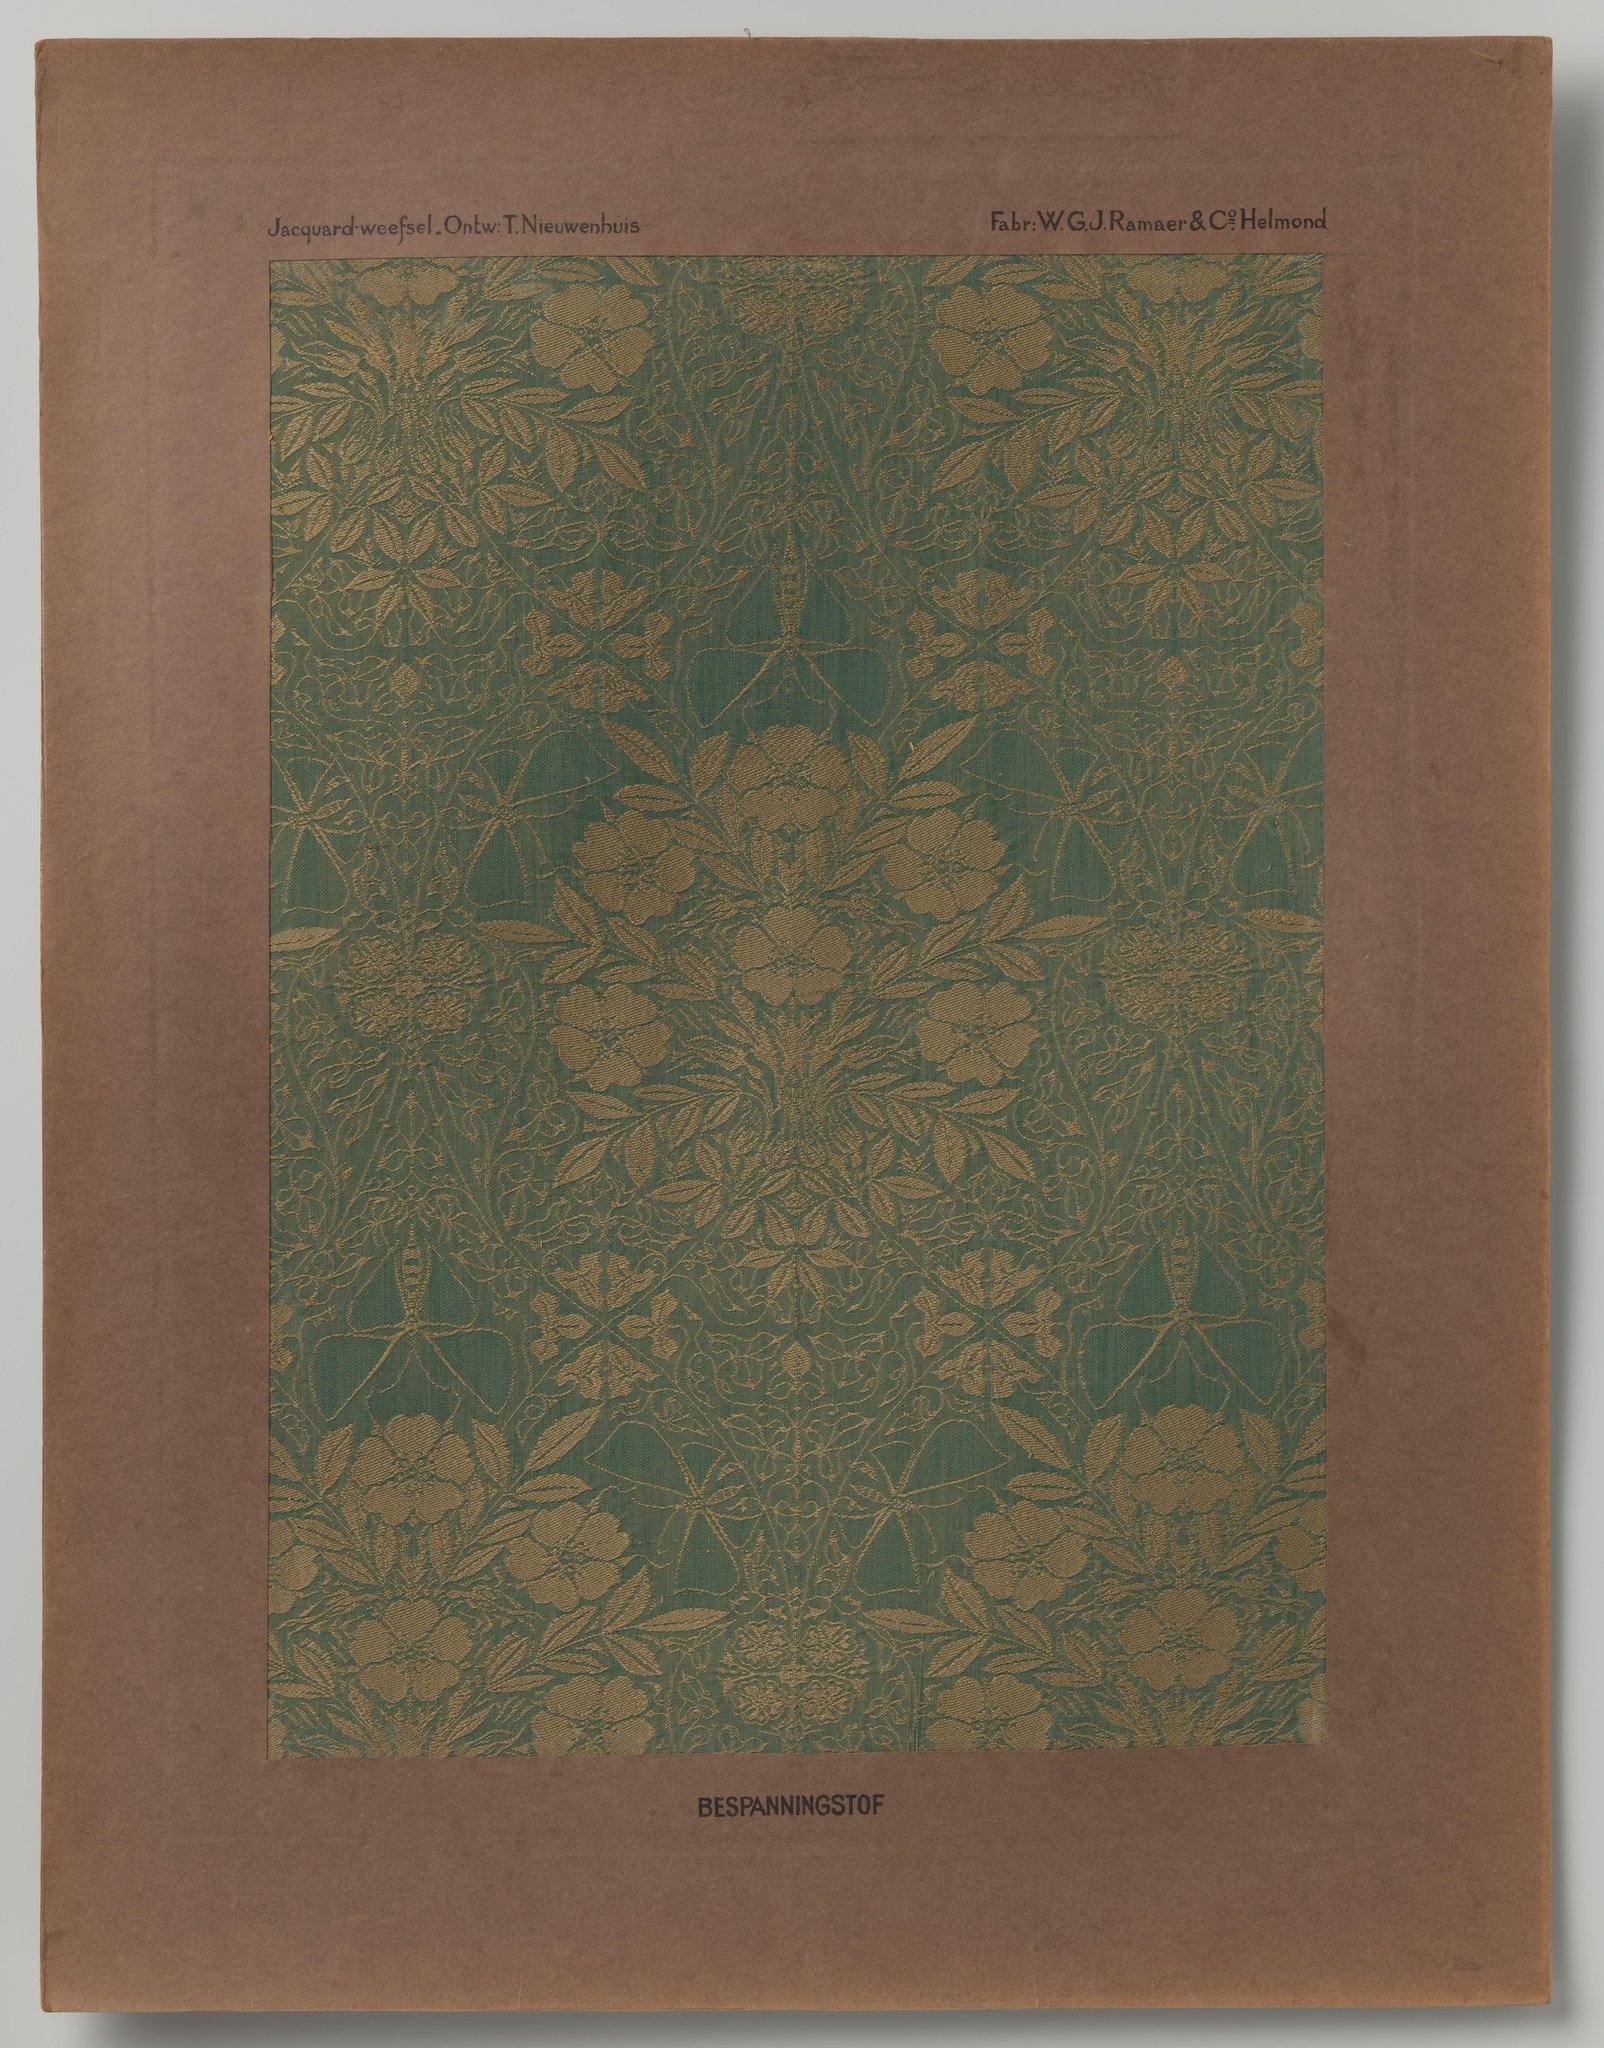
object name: sample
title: Staal bespanningsstof naar ontwerp van Theo Nieuwenhuis in passe-partout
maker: theo nieuwenhuis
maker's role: designer, draughtsman, print maker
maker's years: 1866-1951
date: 1910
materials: cardboard, cotton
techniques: jacquard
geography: helmond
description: Staal bespanningsstof van jacquardgeweven katoen naar ontwerp van Theo Nieuwenhuis, in origineel passe-partout. Floraal motief met geelgroene inslag op groene ketting.